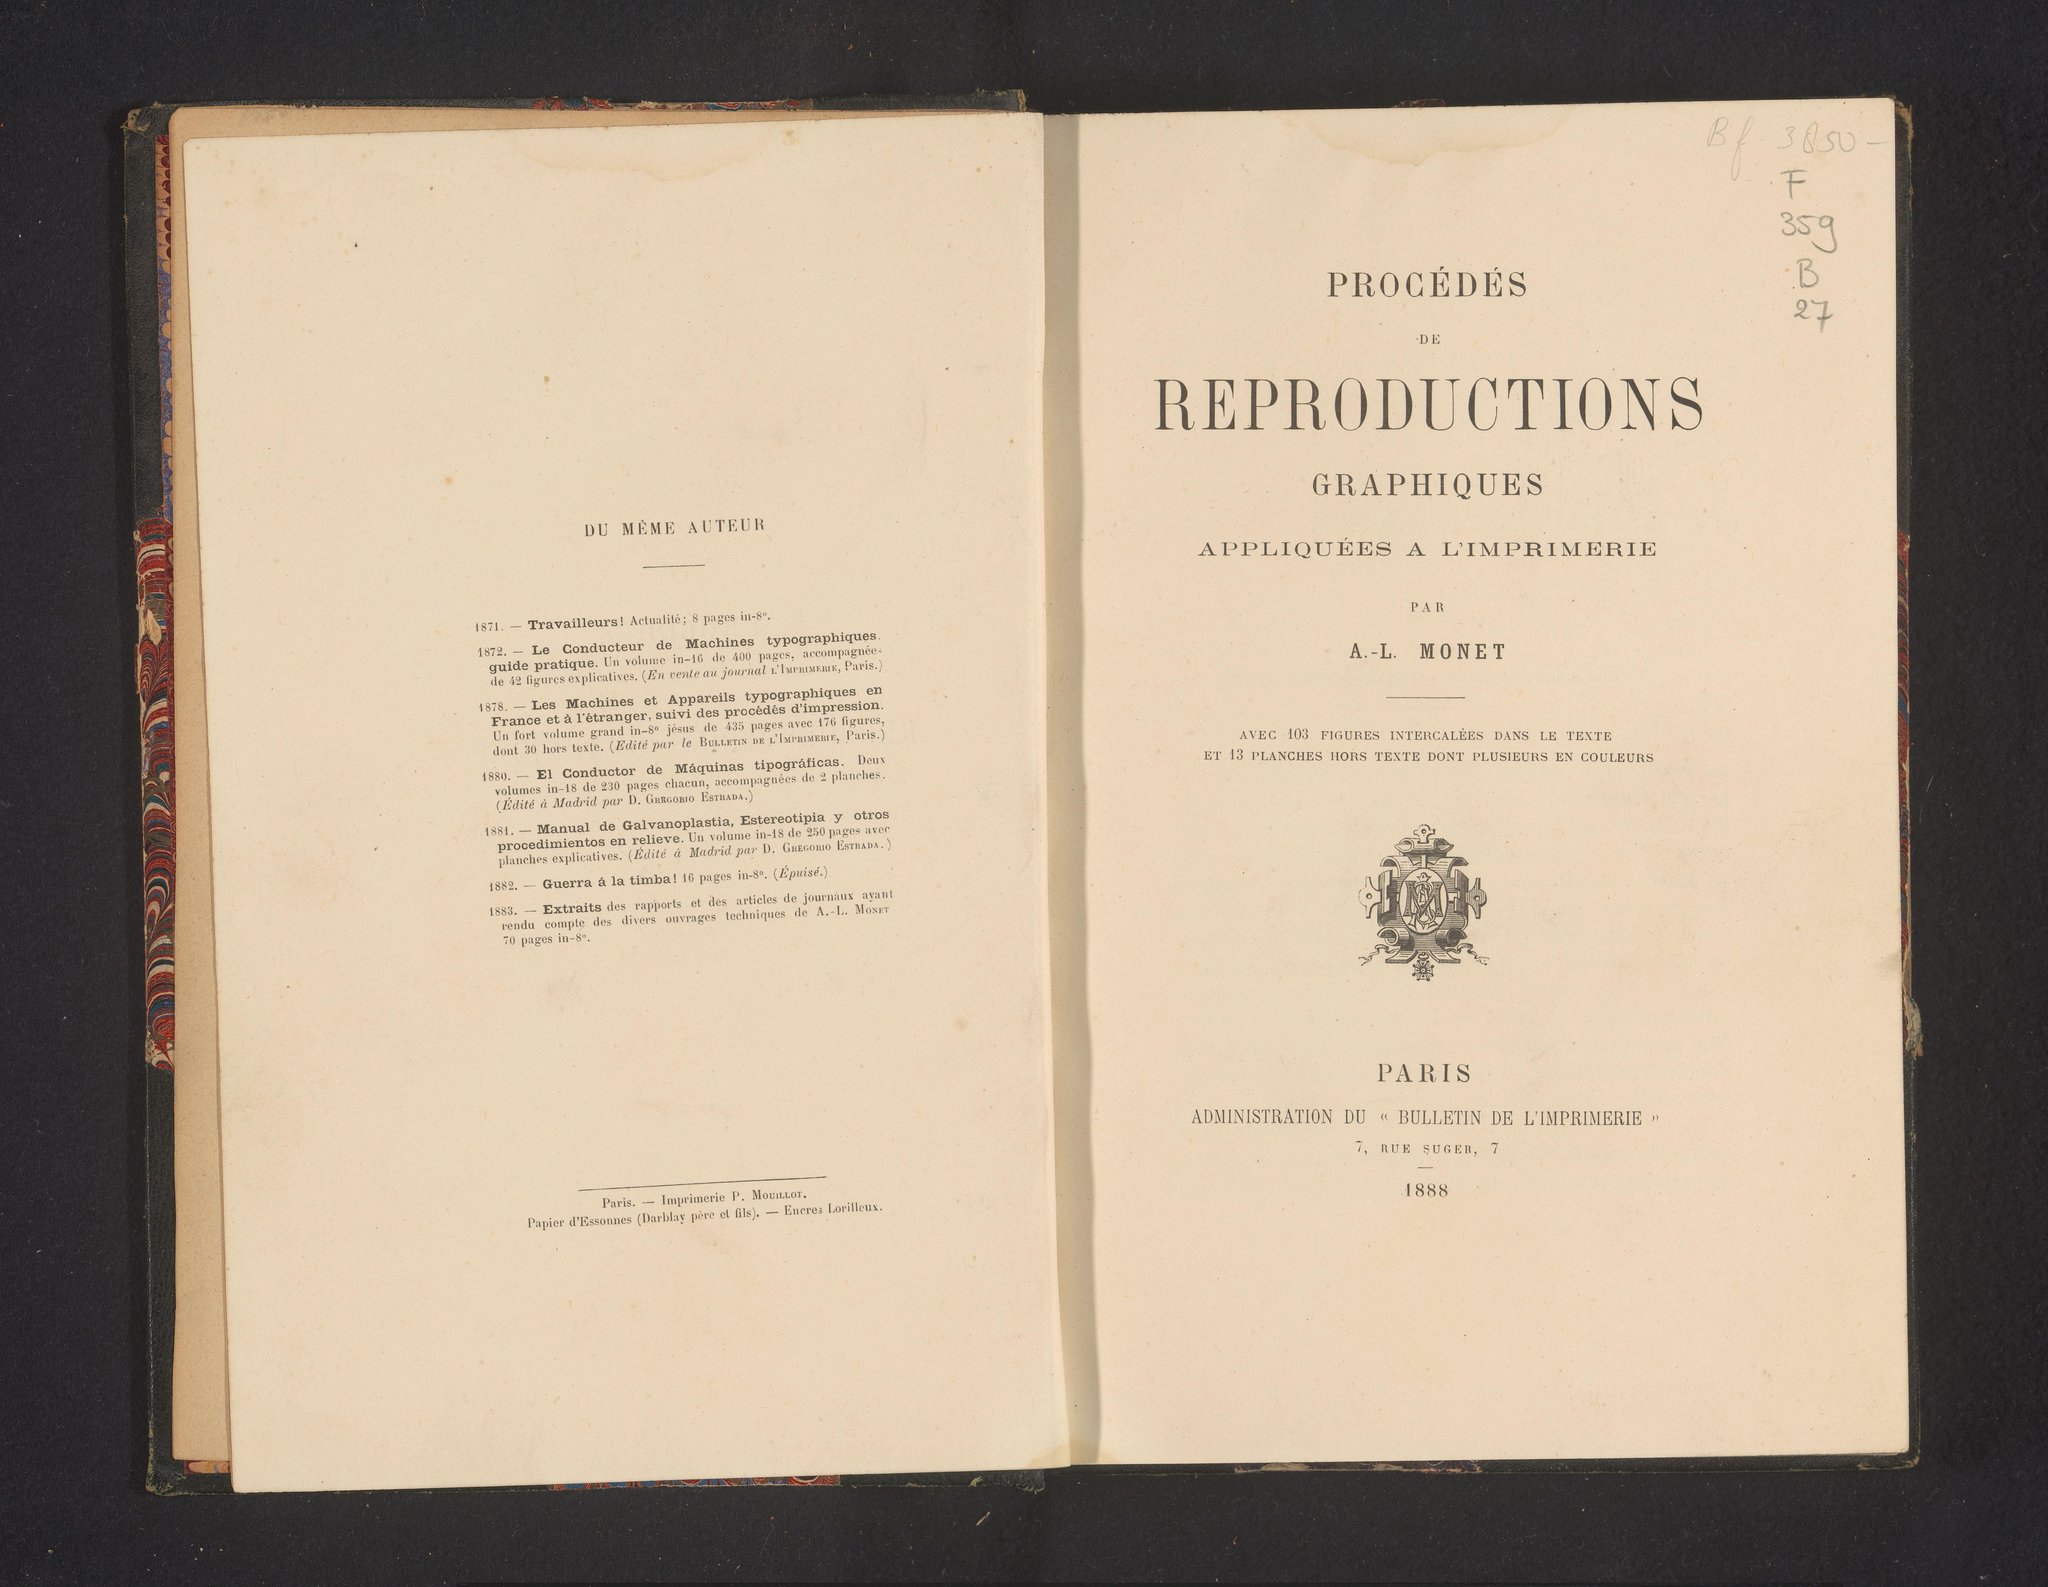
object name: book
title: Procédés de reproductions graphiques appliquées à l'imprimerie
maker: adolphe lucien monet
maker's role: schrijver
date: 1888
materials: cardboard, paper, textile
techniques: chromolithography, marbled paper, printing, woodburytype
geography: paris